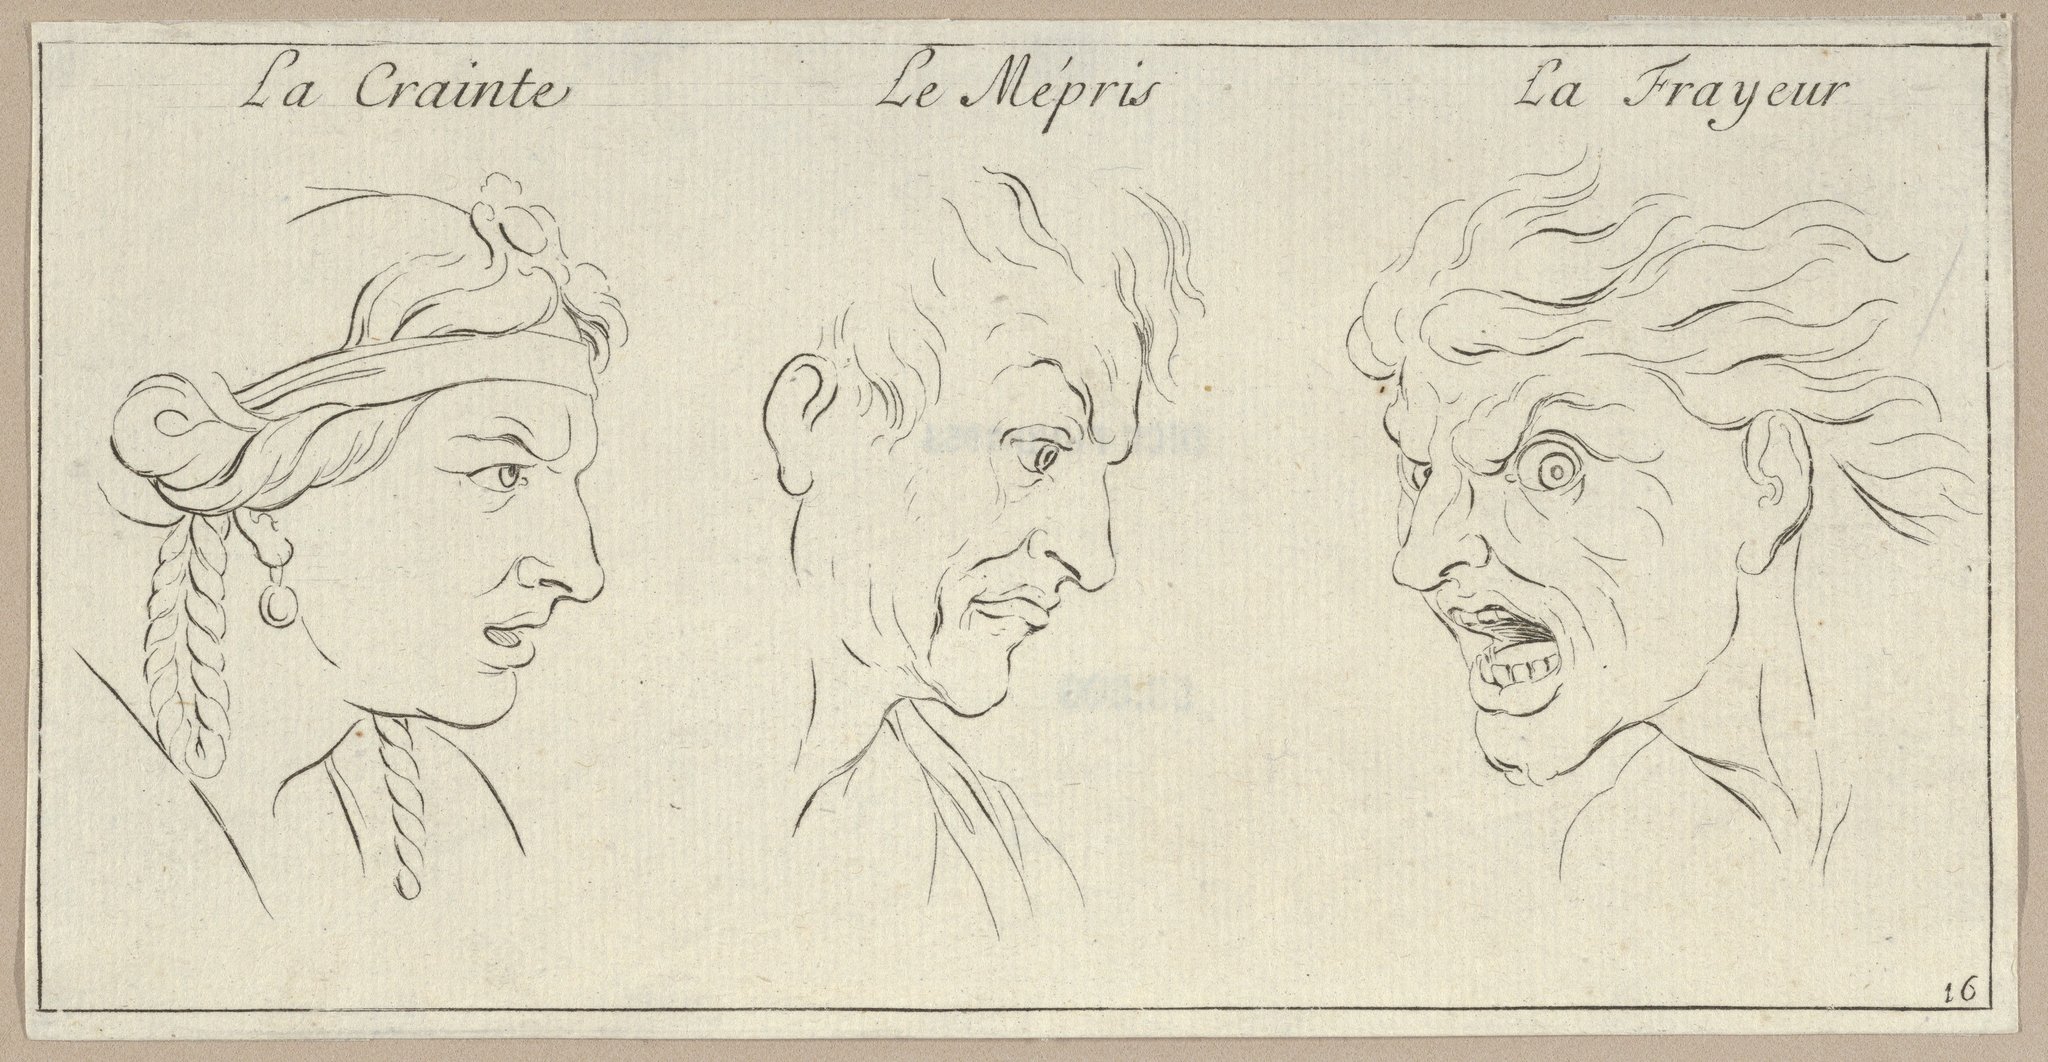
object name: print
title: Le Crainte, Le Mépris, La Frayeur, from "Caractères des passions, gravés sur les desseins de l'illustre Monsieur le Brun"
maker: sébastien le clerc, le jeune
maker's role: etcher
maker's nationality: french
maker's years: 1676-1763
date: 1695-1720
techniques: etching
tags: heads,fear